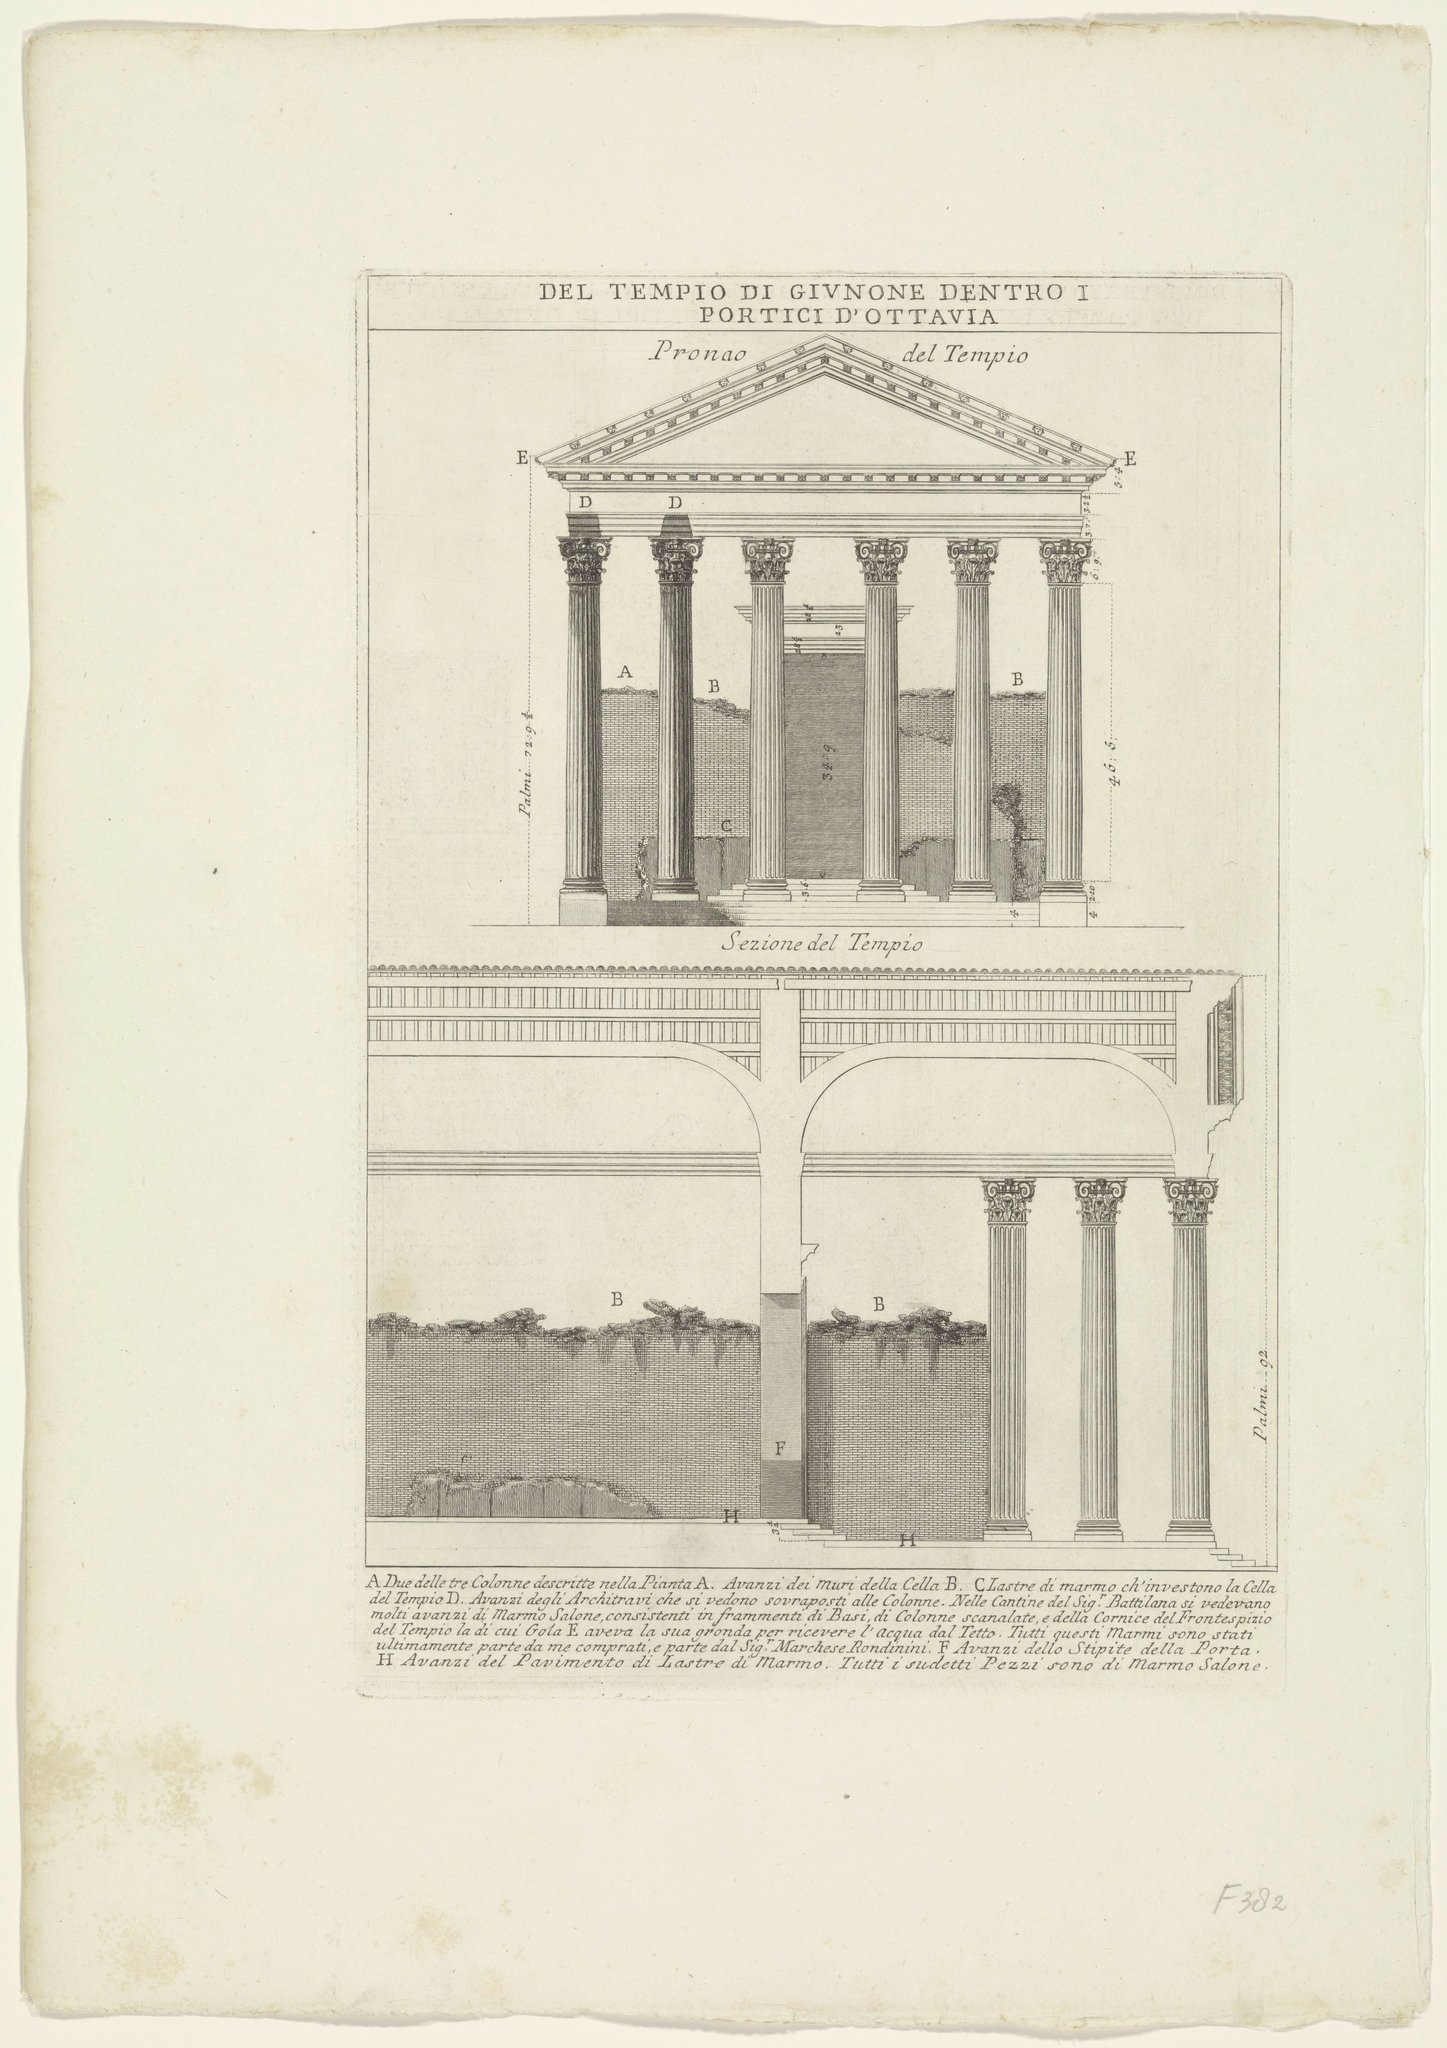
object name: print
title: Voorzijde en doorsnede van de Tempel van Juno Regina te Rome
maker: giovanni battista piranesi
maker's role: designer, draughtsman, print maker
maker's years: 1720-1778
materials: paper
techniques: etching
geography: rome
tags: temple, shrine ~ roman religion, corinthian order ~ architecture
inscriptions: collector's mark: Lugt 2228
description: Deze prent werd toegevoegd in de tweede editie van de serie 'Le Antichità Romane'. Piranesi deed meer dan acht jaar voorstudie voor deze 250 platen tellende serie die in vier volumes werd uitgegeven. Hij produceerde de prenten tussen ca. 1756 en 1757. In 1784 werd de tweede editie uitgegeven. De serie bevat ook prenten door of naar andere prentmakers, onder wie Francesco Bianchini en Girolamo Rossi.